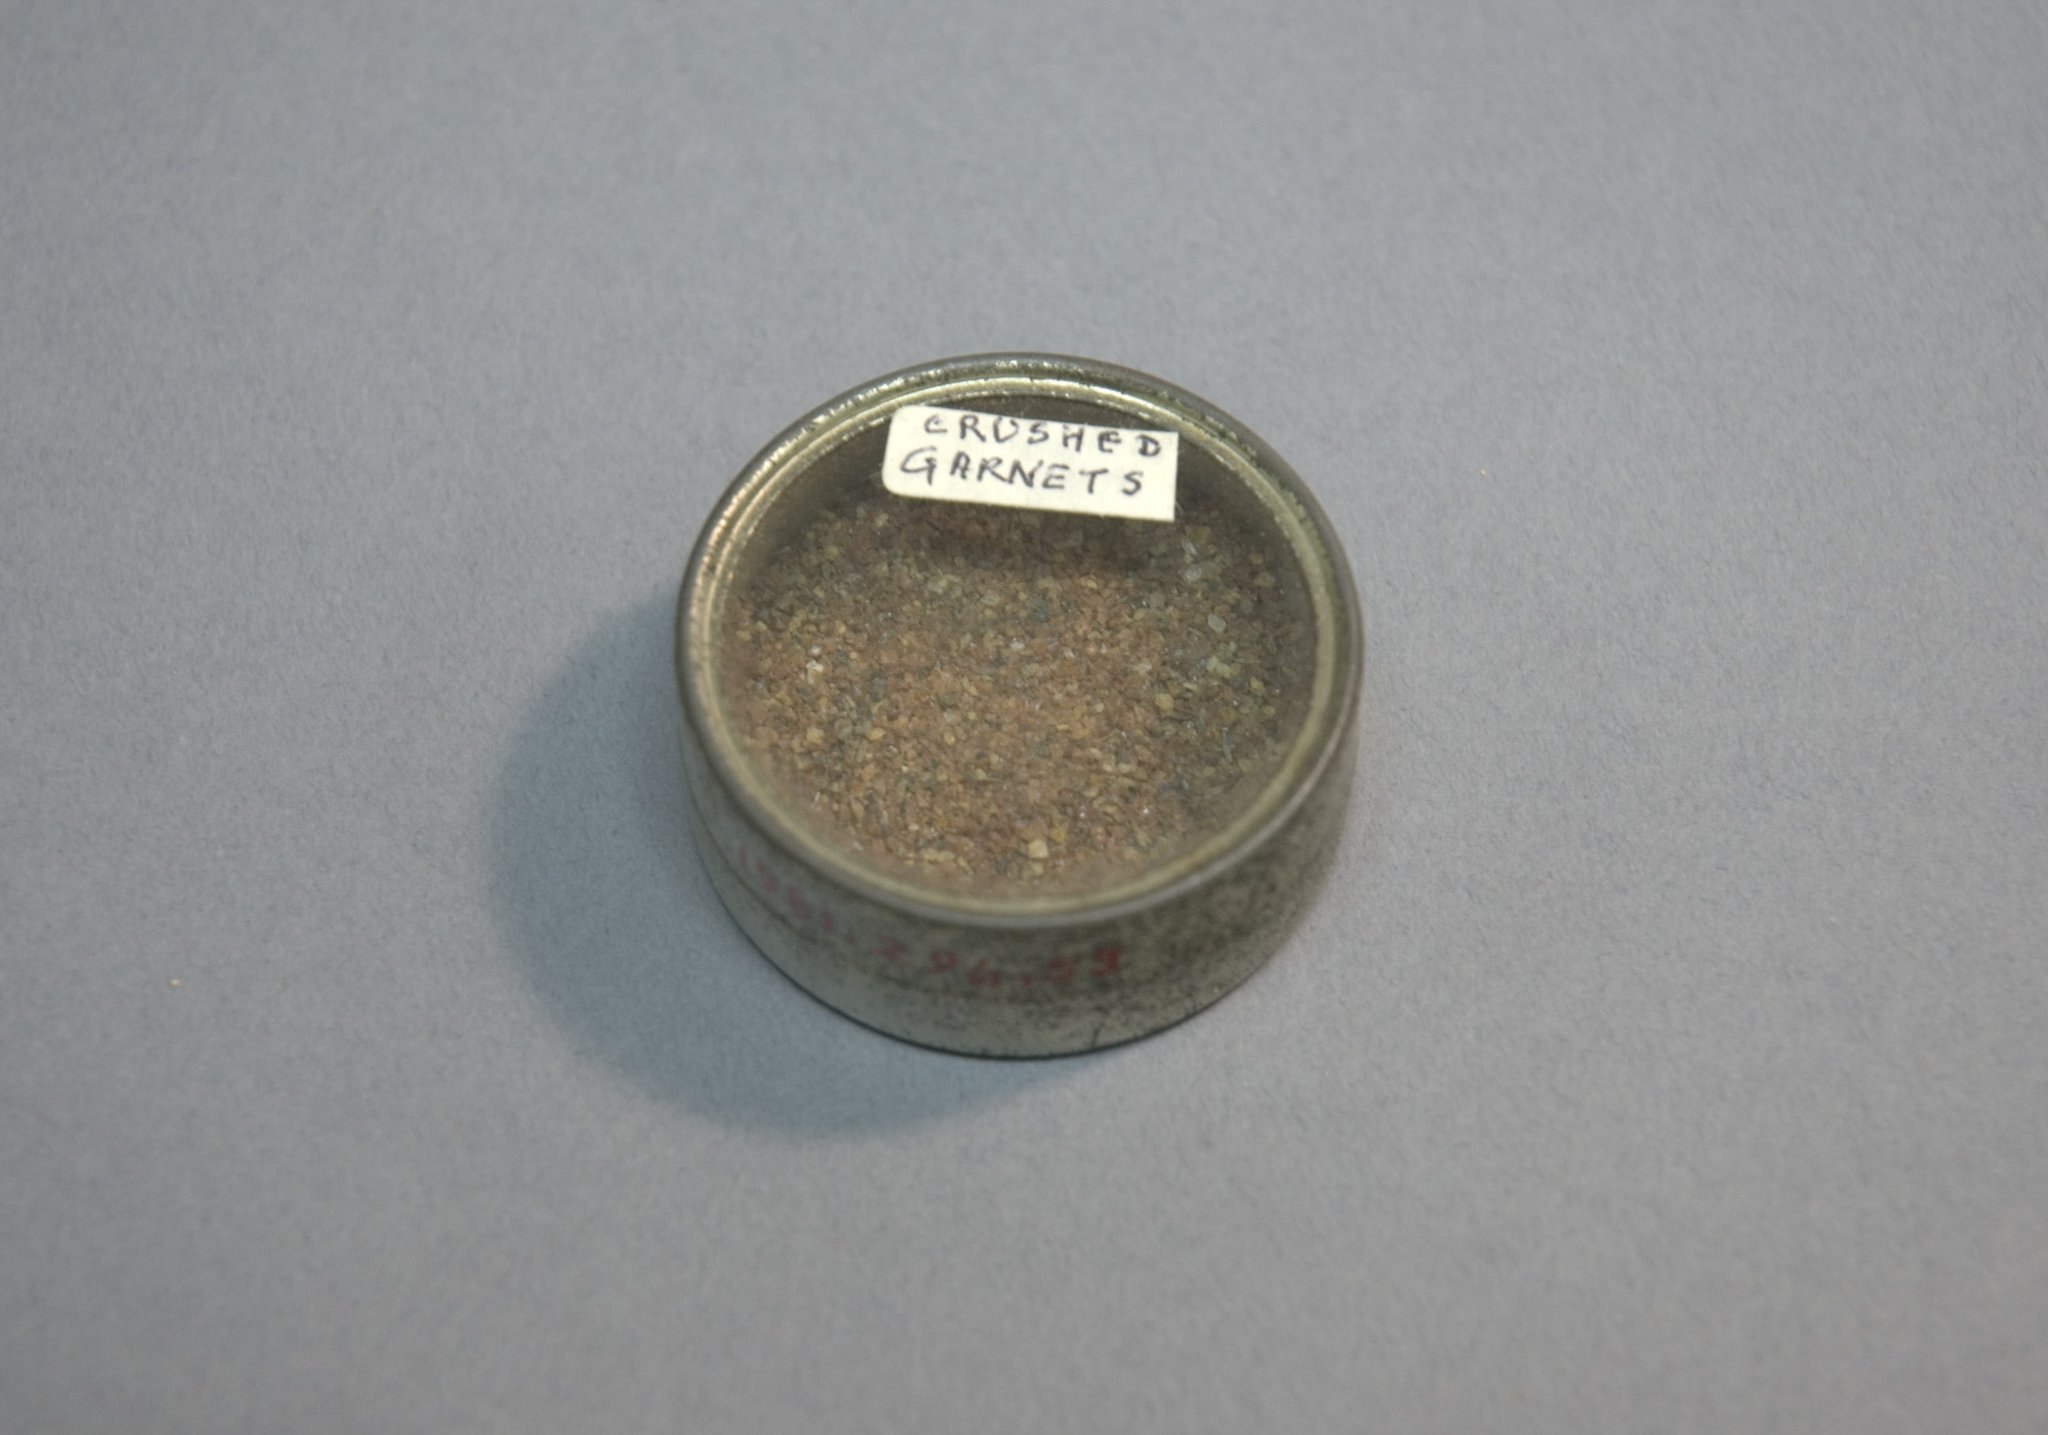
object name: jade carving material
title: Container of Crushed Garnets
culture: chinese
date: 1901-2000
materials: gemstone